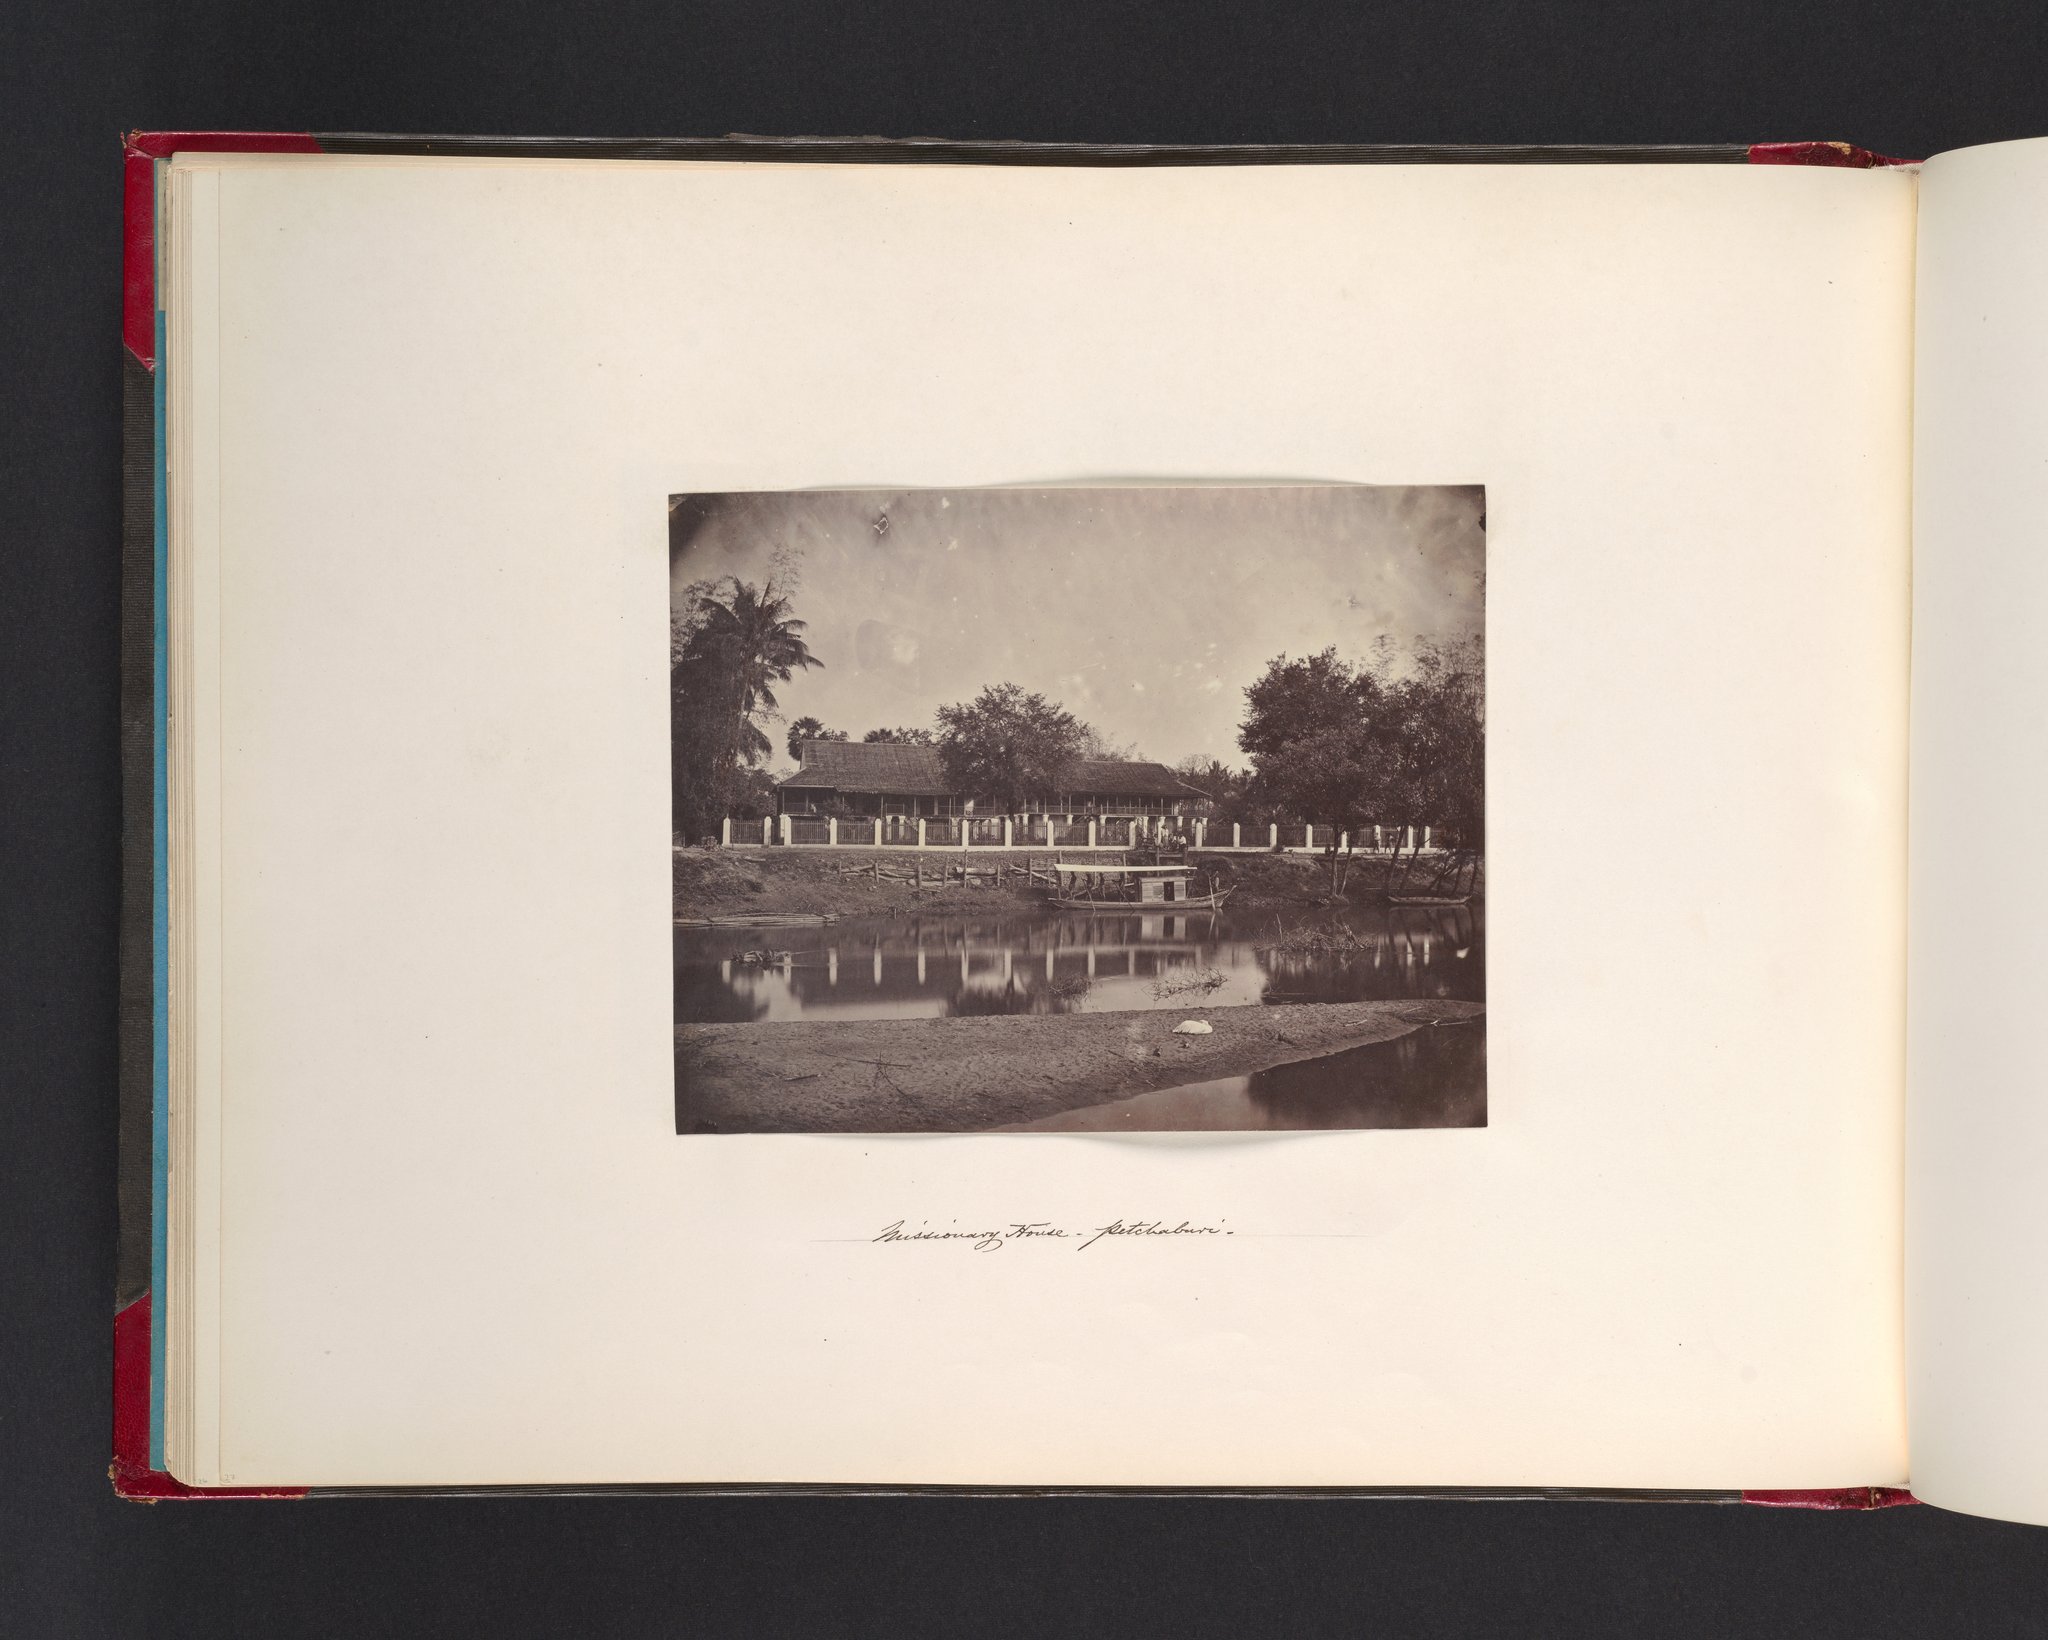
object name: photograph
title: Missionary House, Petchaburi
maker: john thomson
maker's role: artist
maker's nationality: british, scottish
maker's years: 1837-1921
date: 1865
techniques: albumen silver print, glass negative